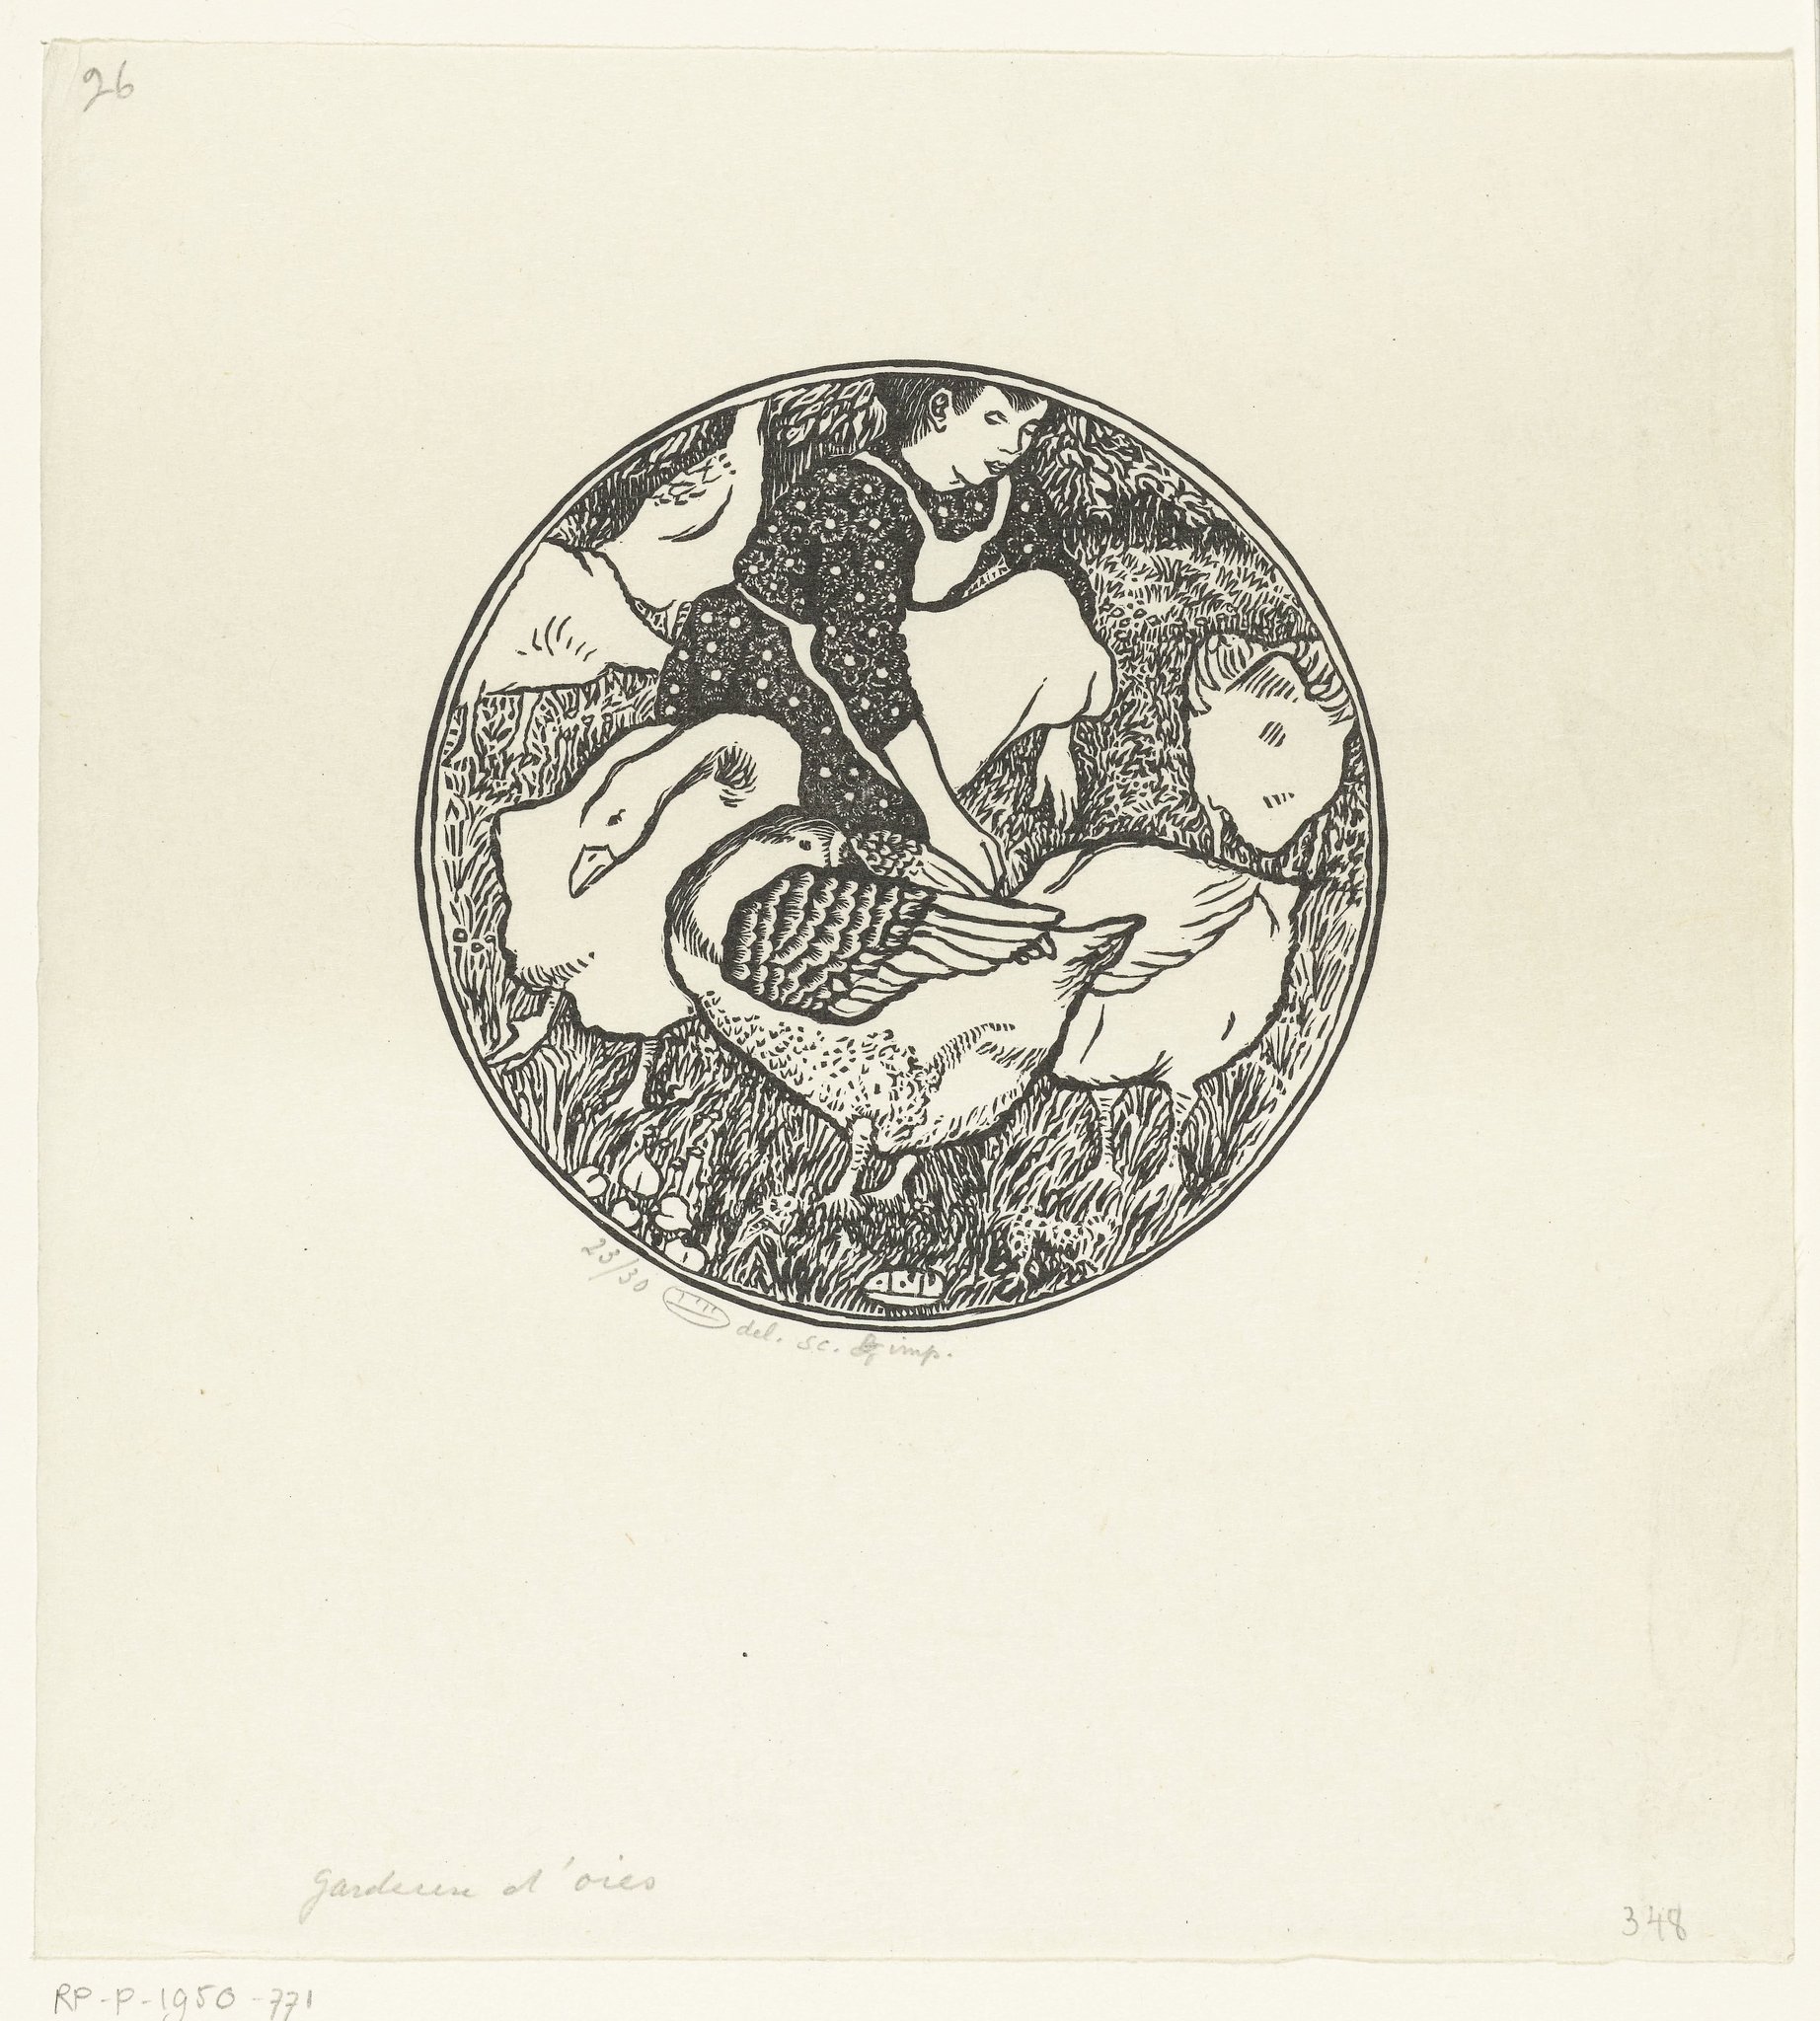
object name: print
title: Gardeuse d'oies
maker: lucien pissarro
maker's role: painter, print maker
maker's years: 1863-1944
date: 1923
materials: paper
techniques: engraving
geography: hammersmith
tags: herding, herdsman, herdswoman, shepherd, shepherdess, cowherd, etc., geese (domestic waterbirds)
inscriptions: collector's mark: Lugt 2228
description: De ganzenhoedtser geknield tussen haar ganzen.